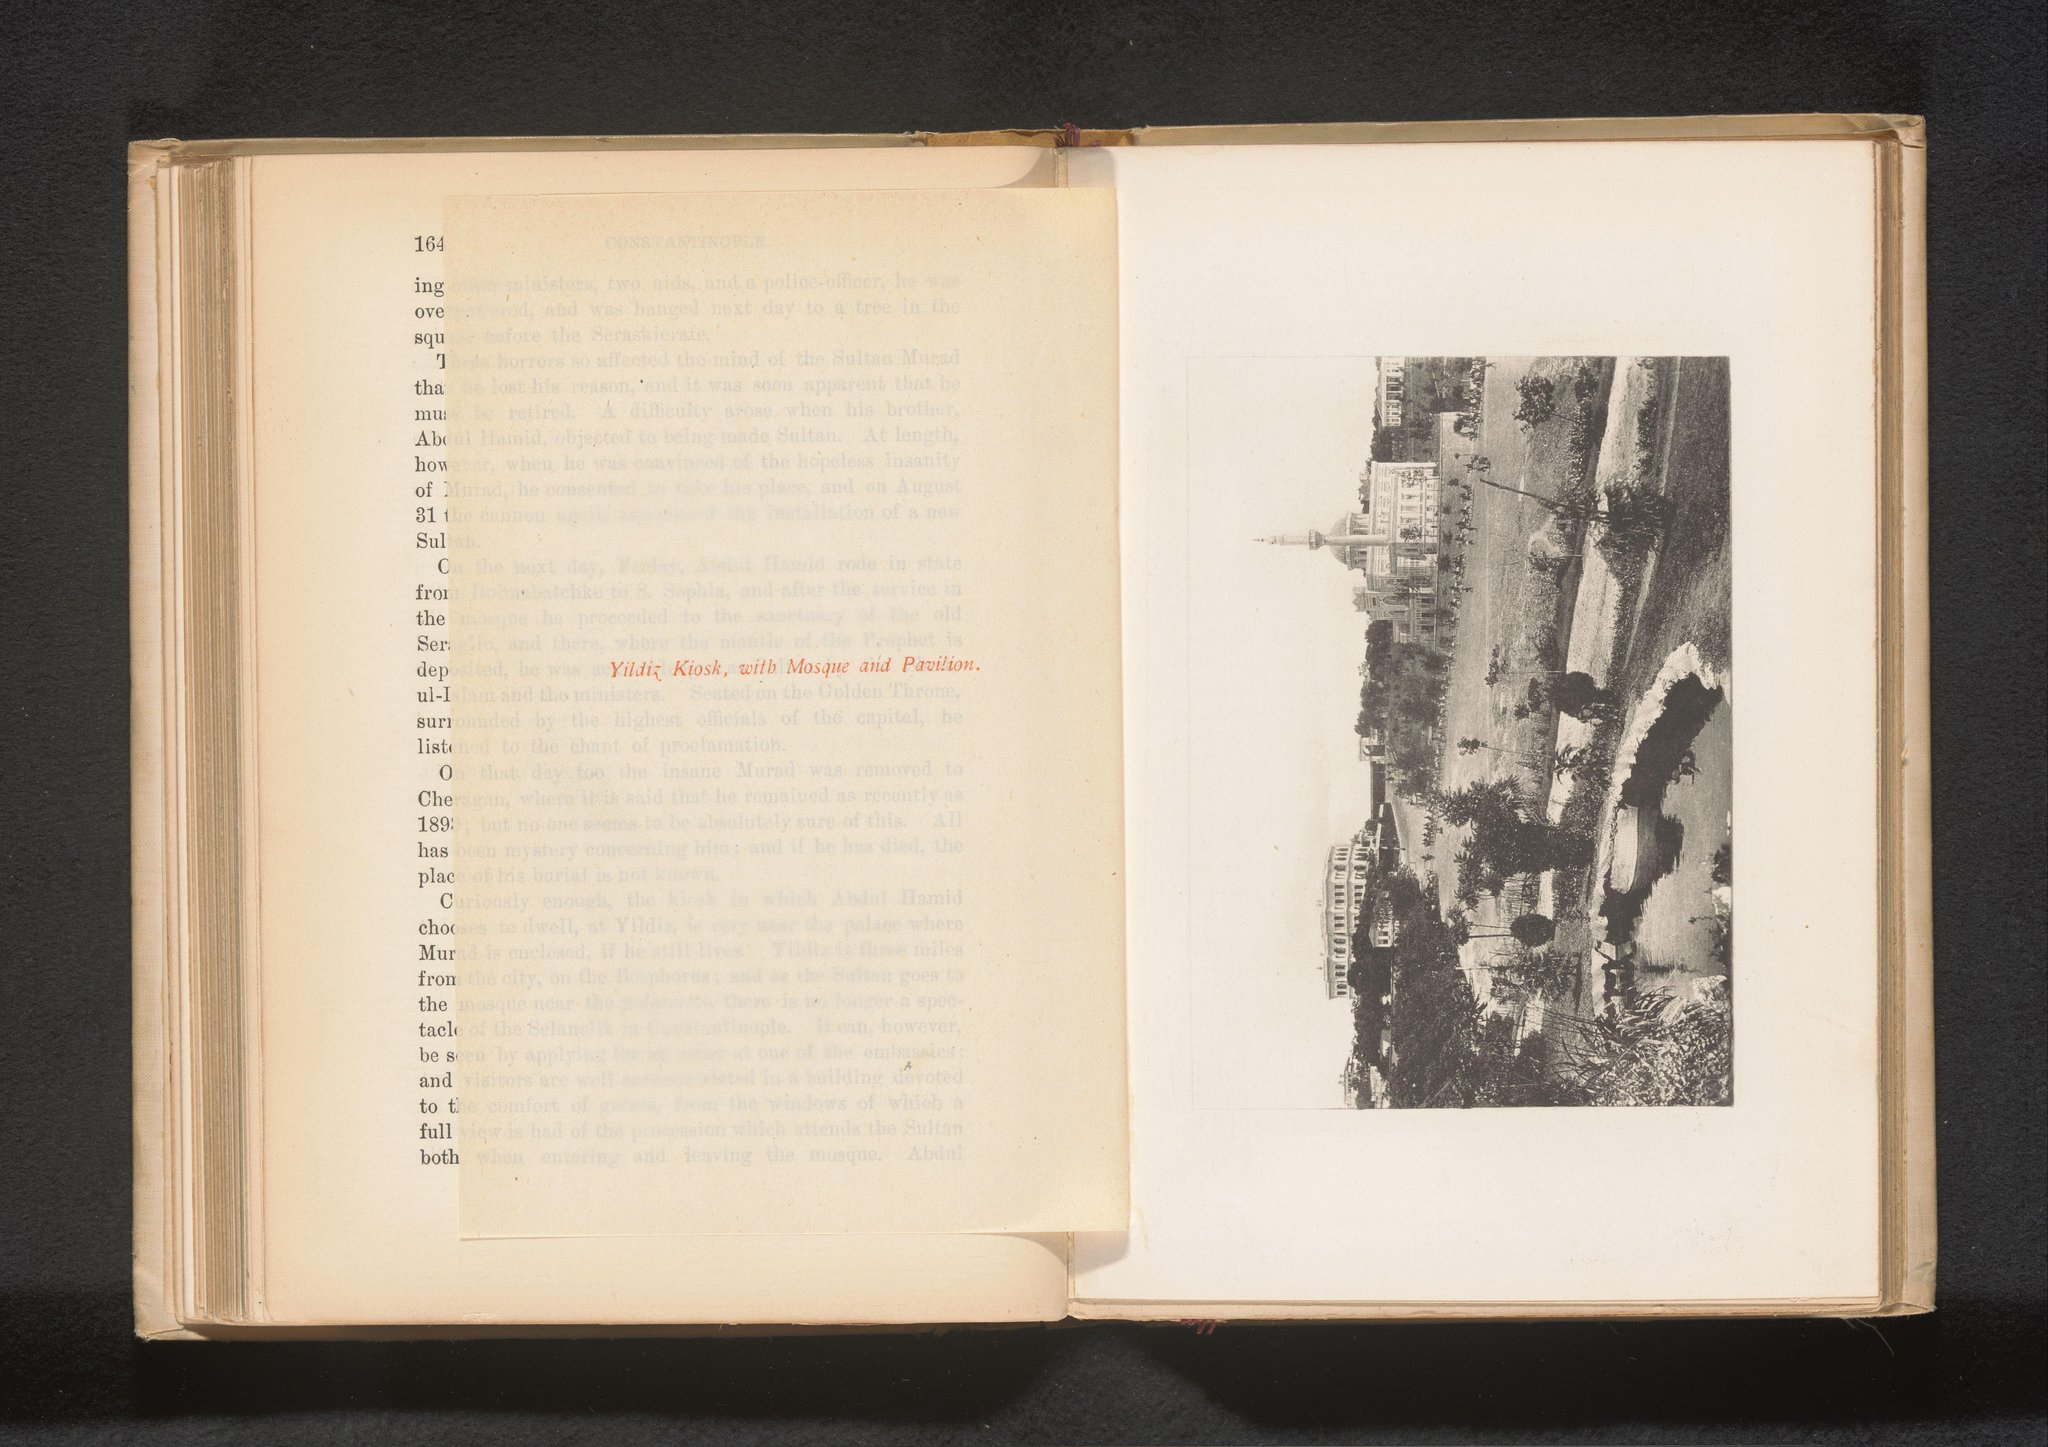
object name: page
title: Gezicht op het park van het Yıldız-paleis te Constantinopel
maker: Anonymous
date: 1885-1895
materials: paper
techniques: photoaquatint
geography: constantinople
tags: palace, public gardens, park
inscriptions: title: ‘Yildiz Kiosk, with Mosque and Pavilion.’